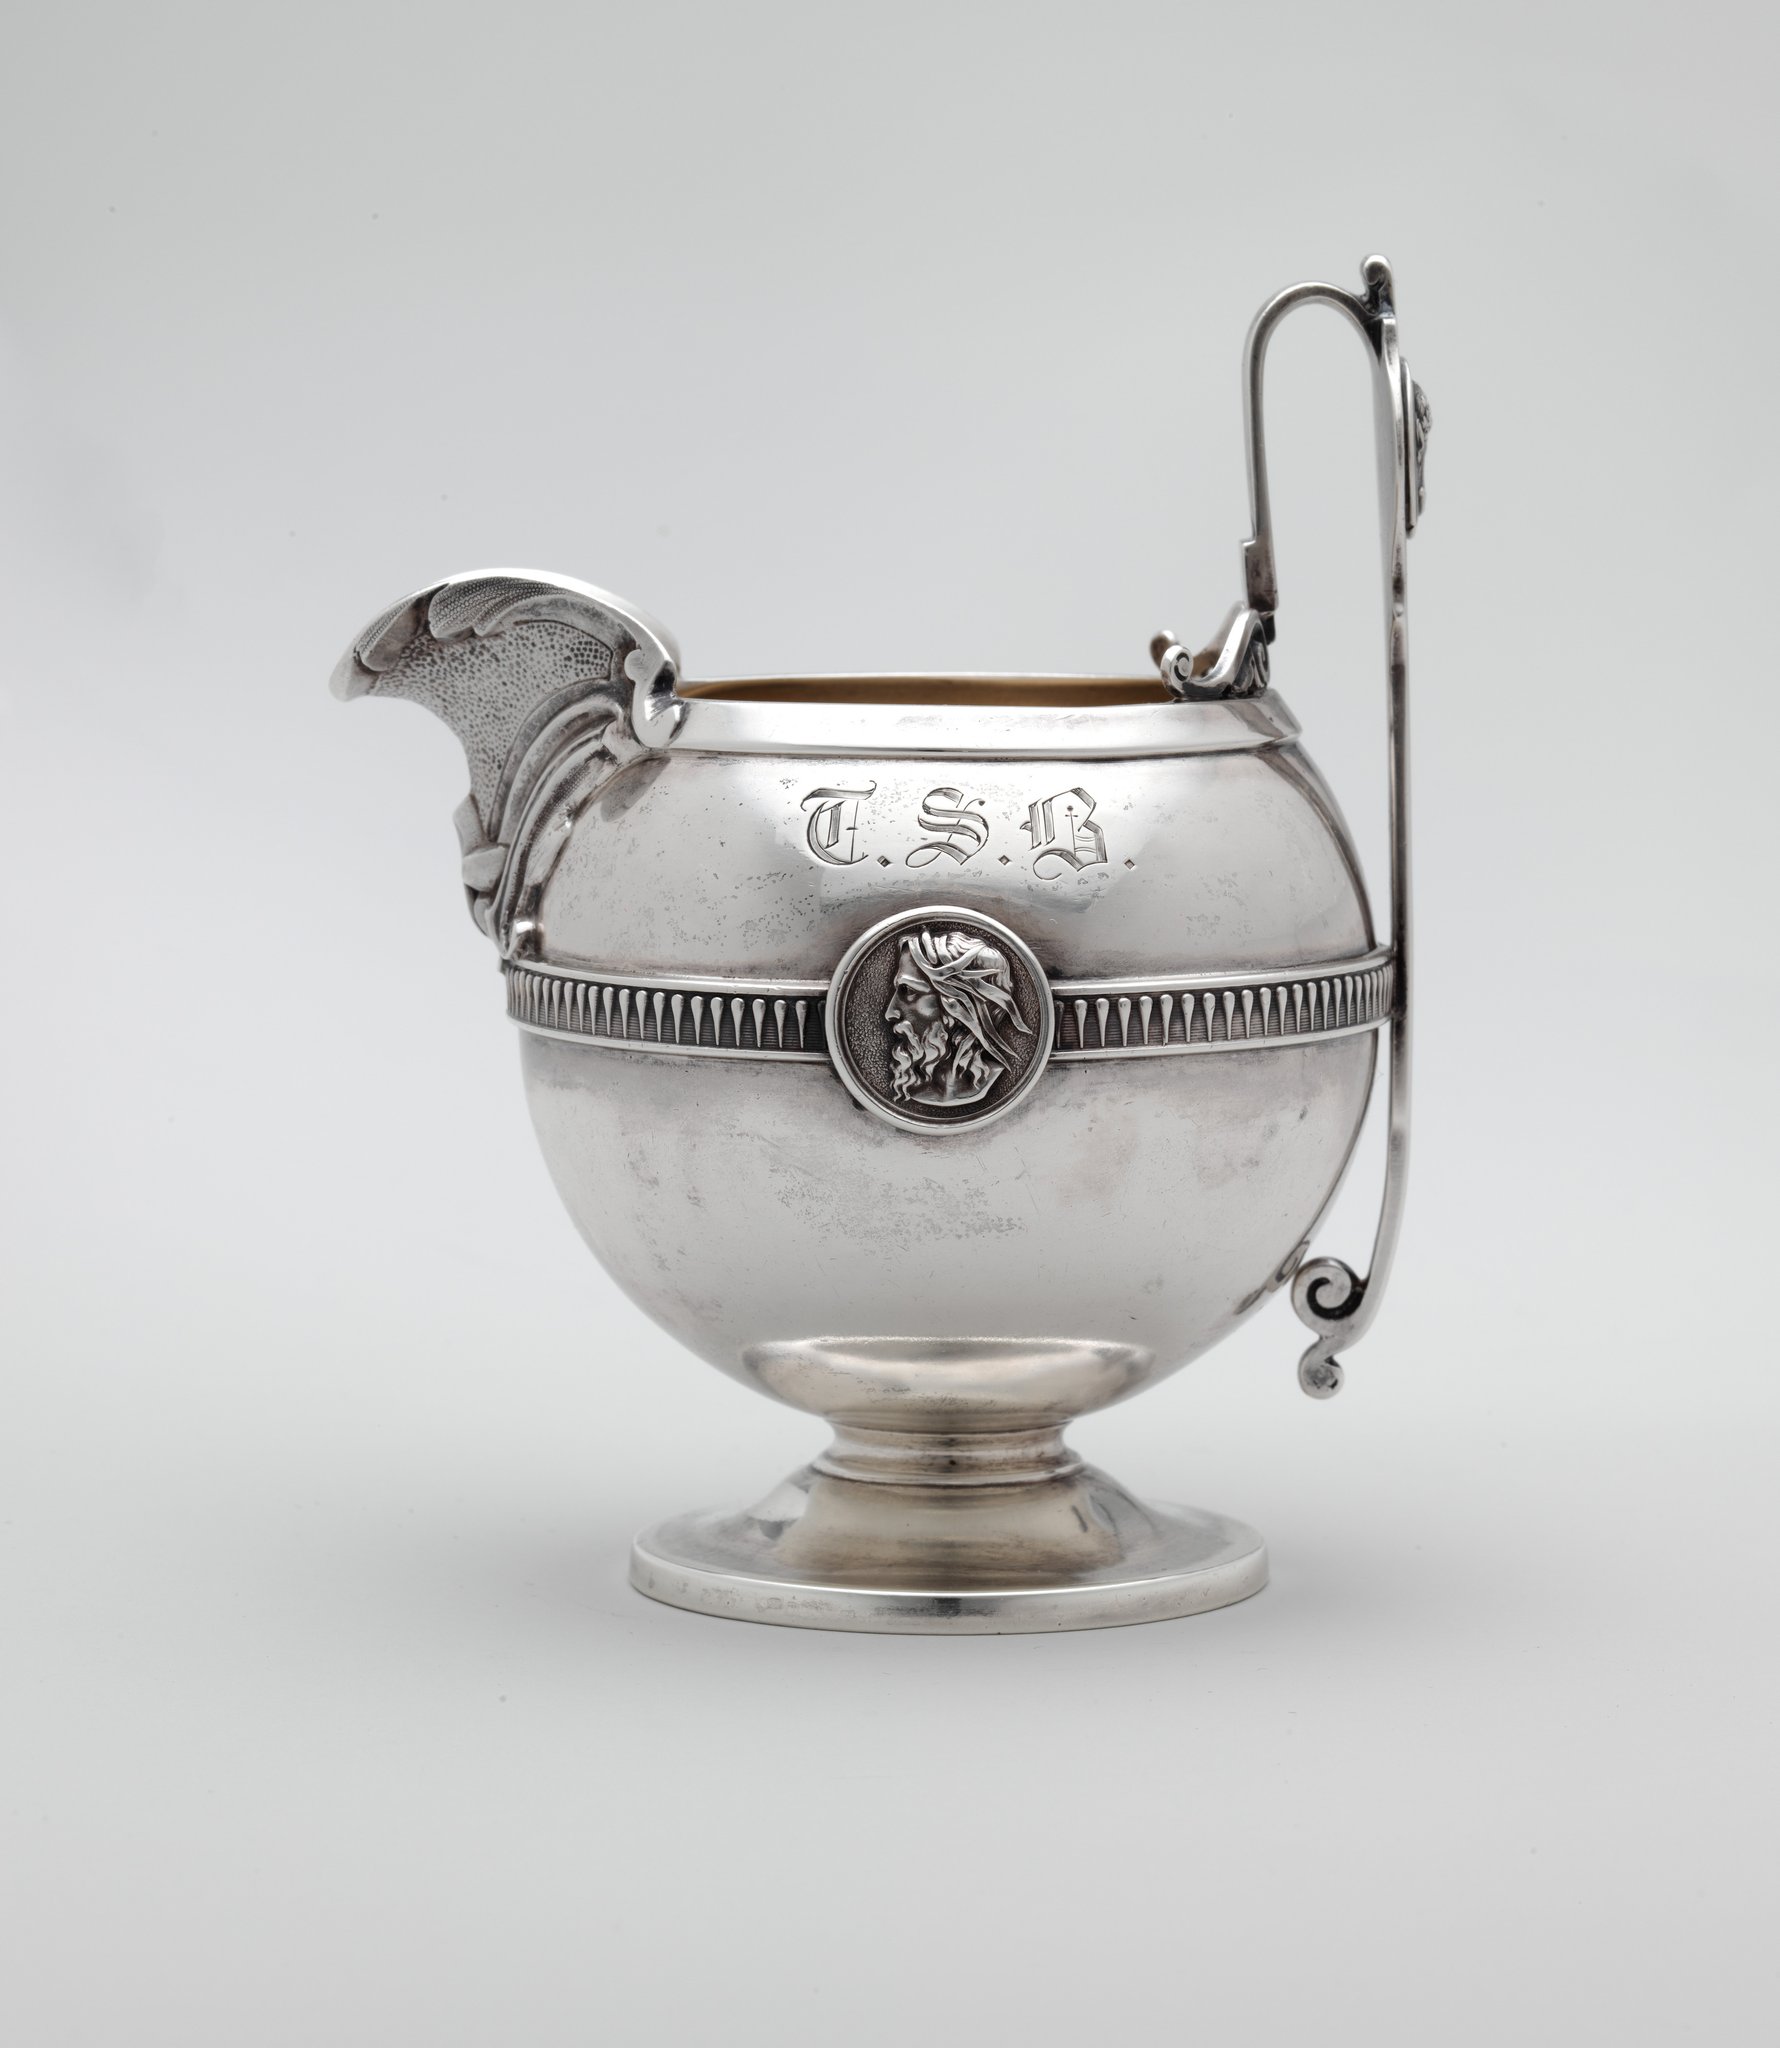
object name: creamer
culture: american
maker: gorham manufacturing company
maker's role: maker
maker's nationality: american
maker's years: 1831-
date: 1865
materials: silver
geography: united states